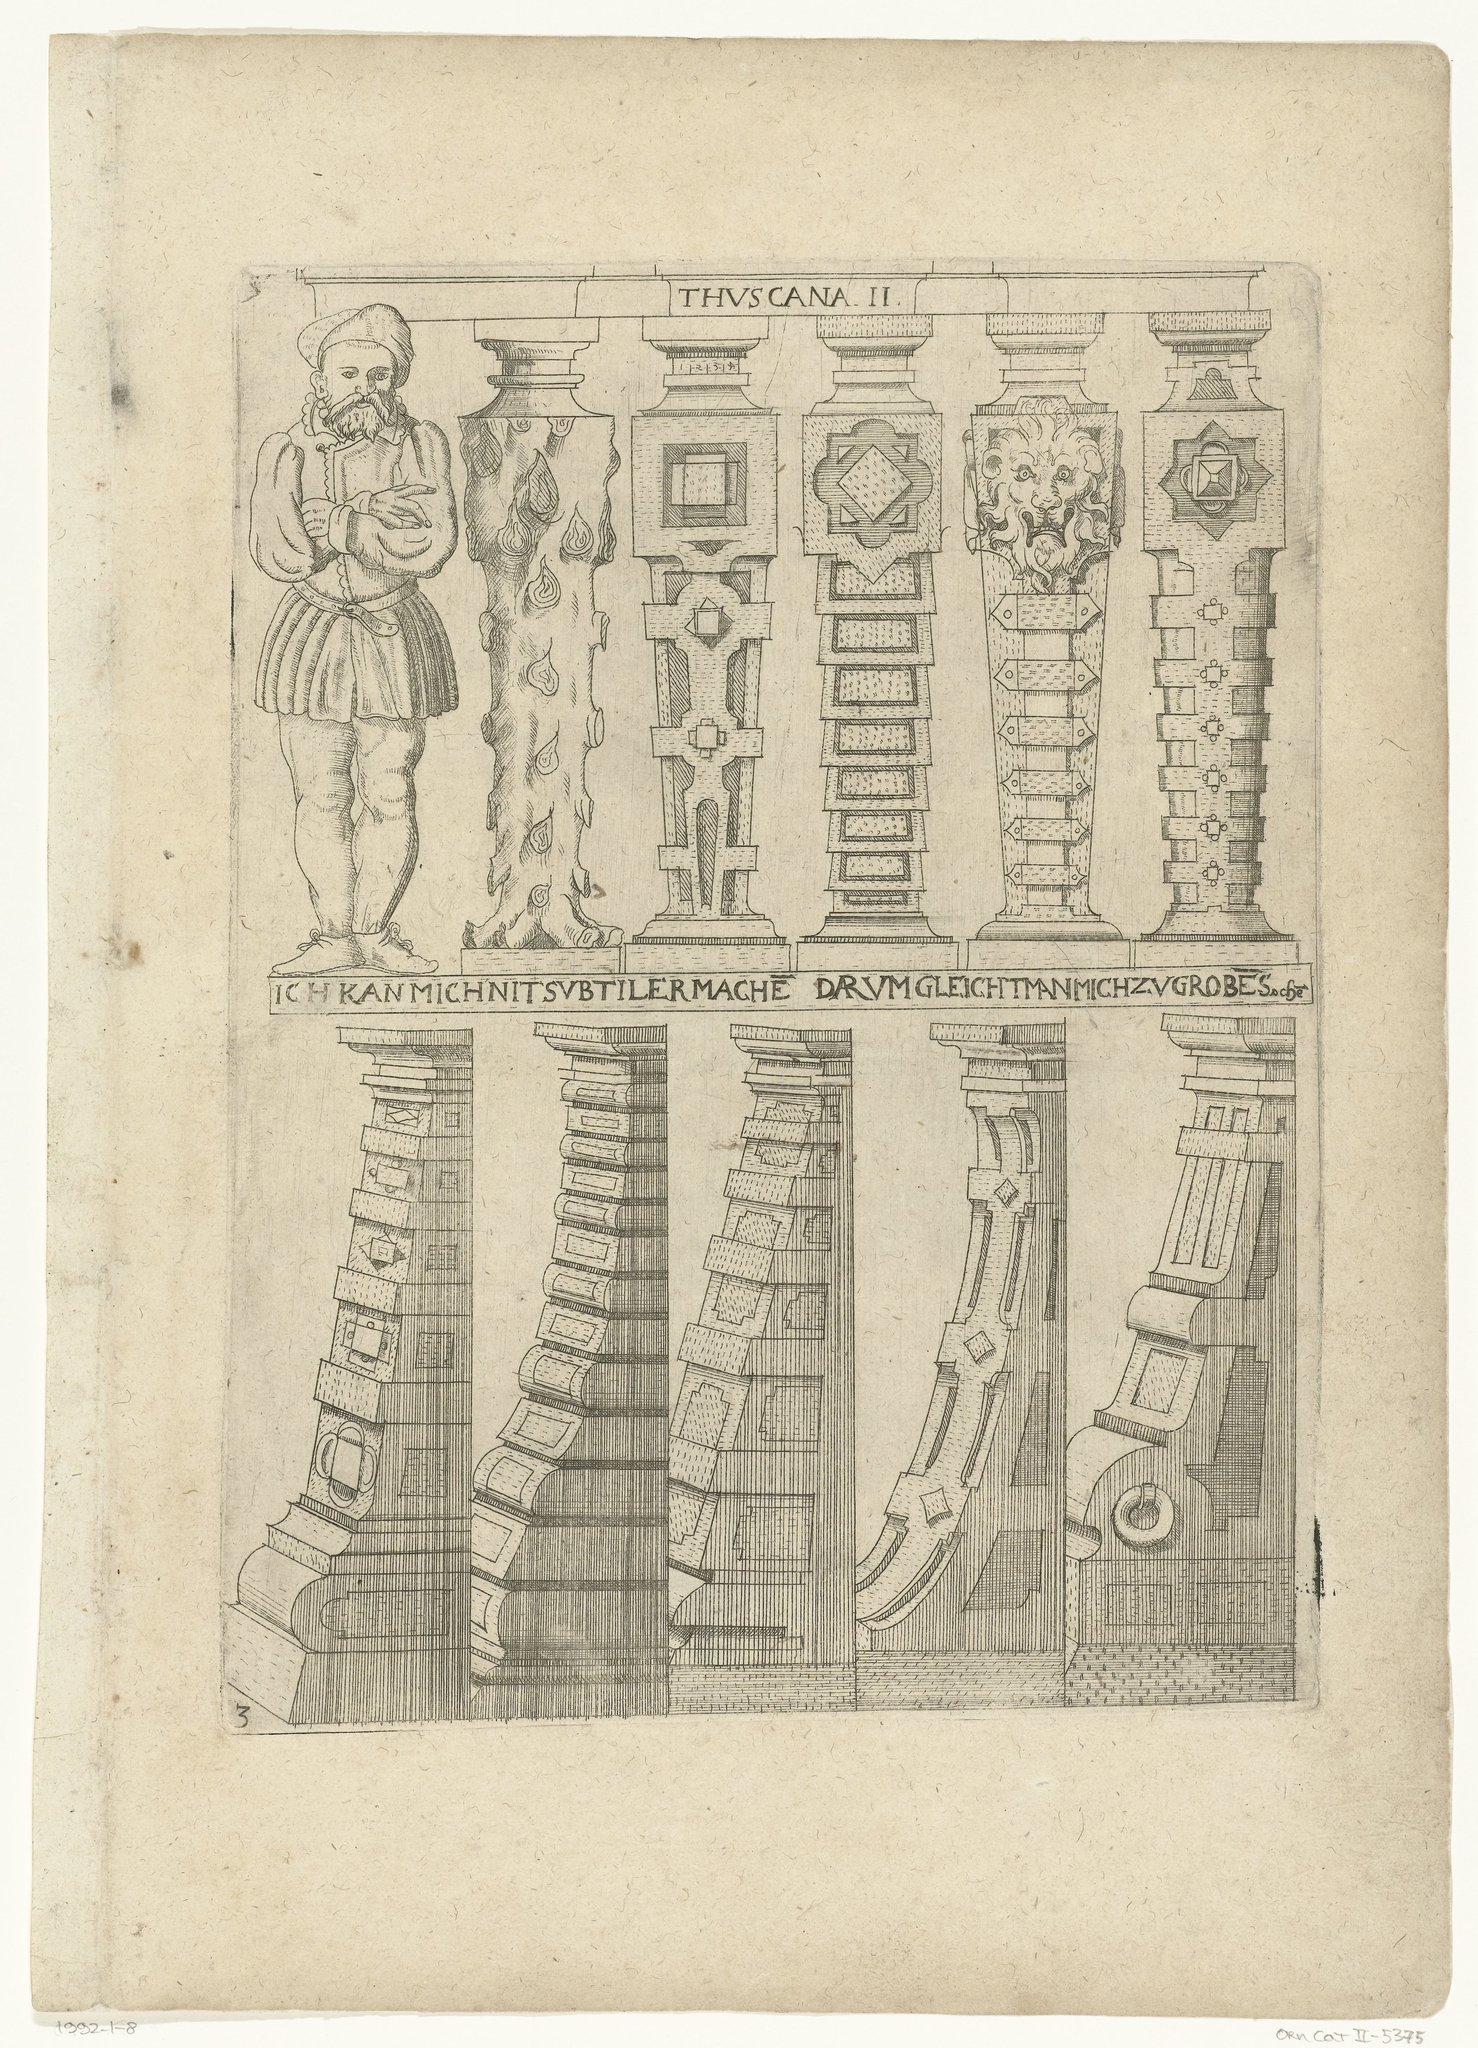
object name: print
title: Thvscana.II / Ich kan mich nit svbtiler mach (...)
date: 1610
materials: paper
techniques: etching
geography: germany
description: Linksboven staat een man met zijn armen over elkaar. Blad 3 uit serie van titelblad en 28 bladen.